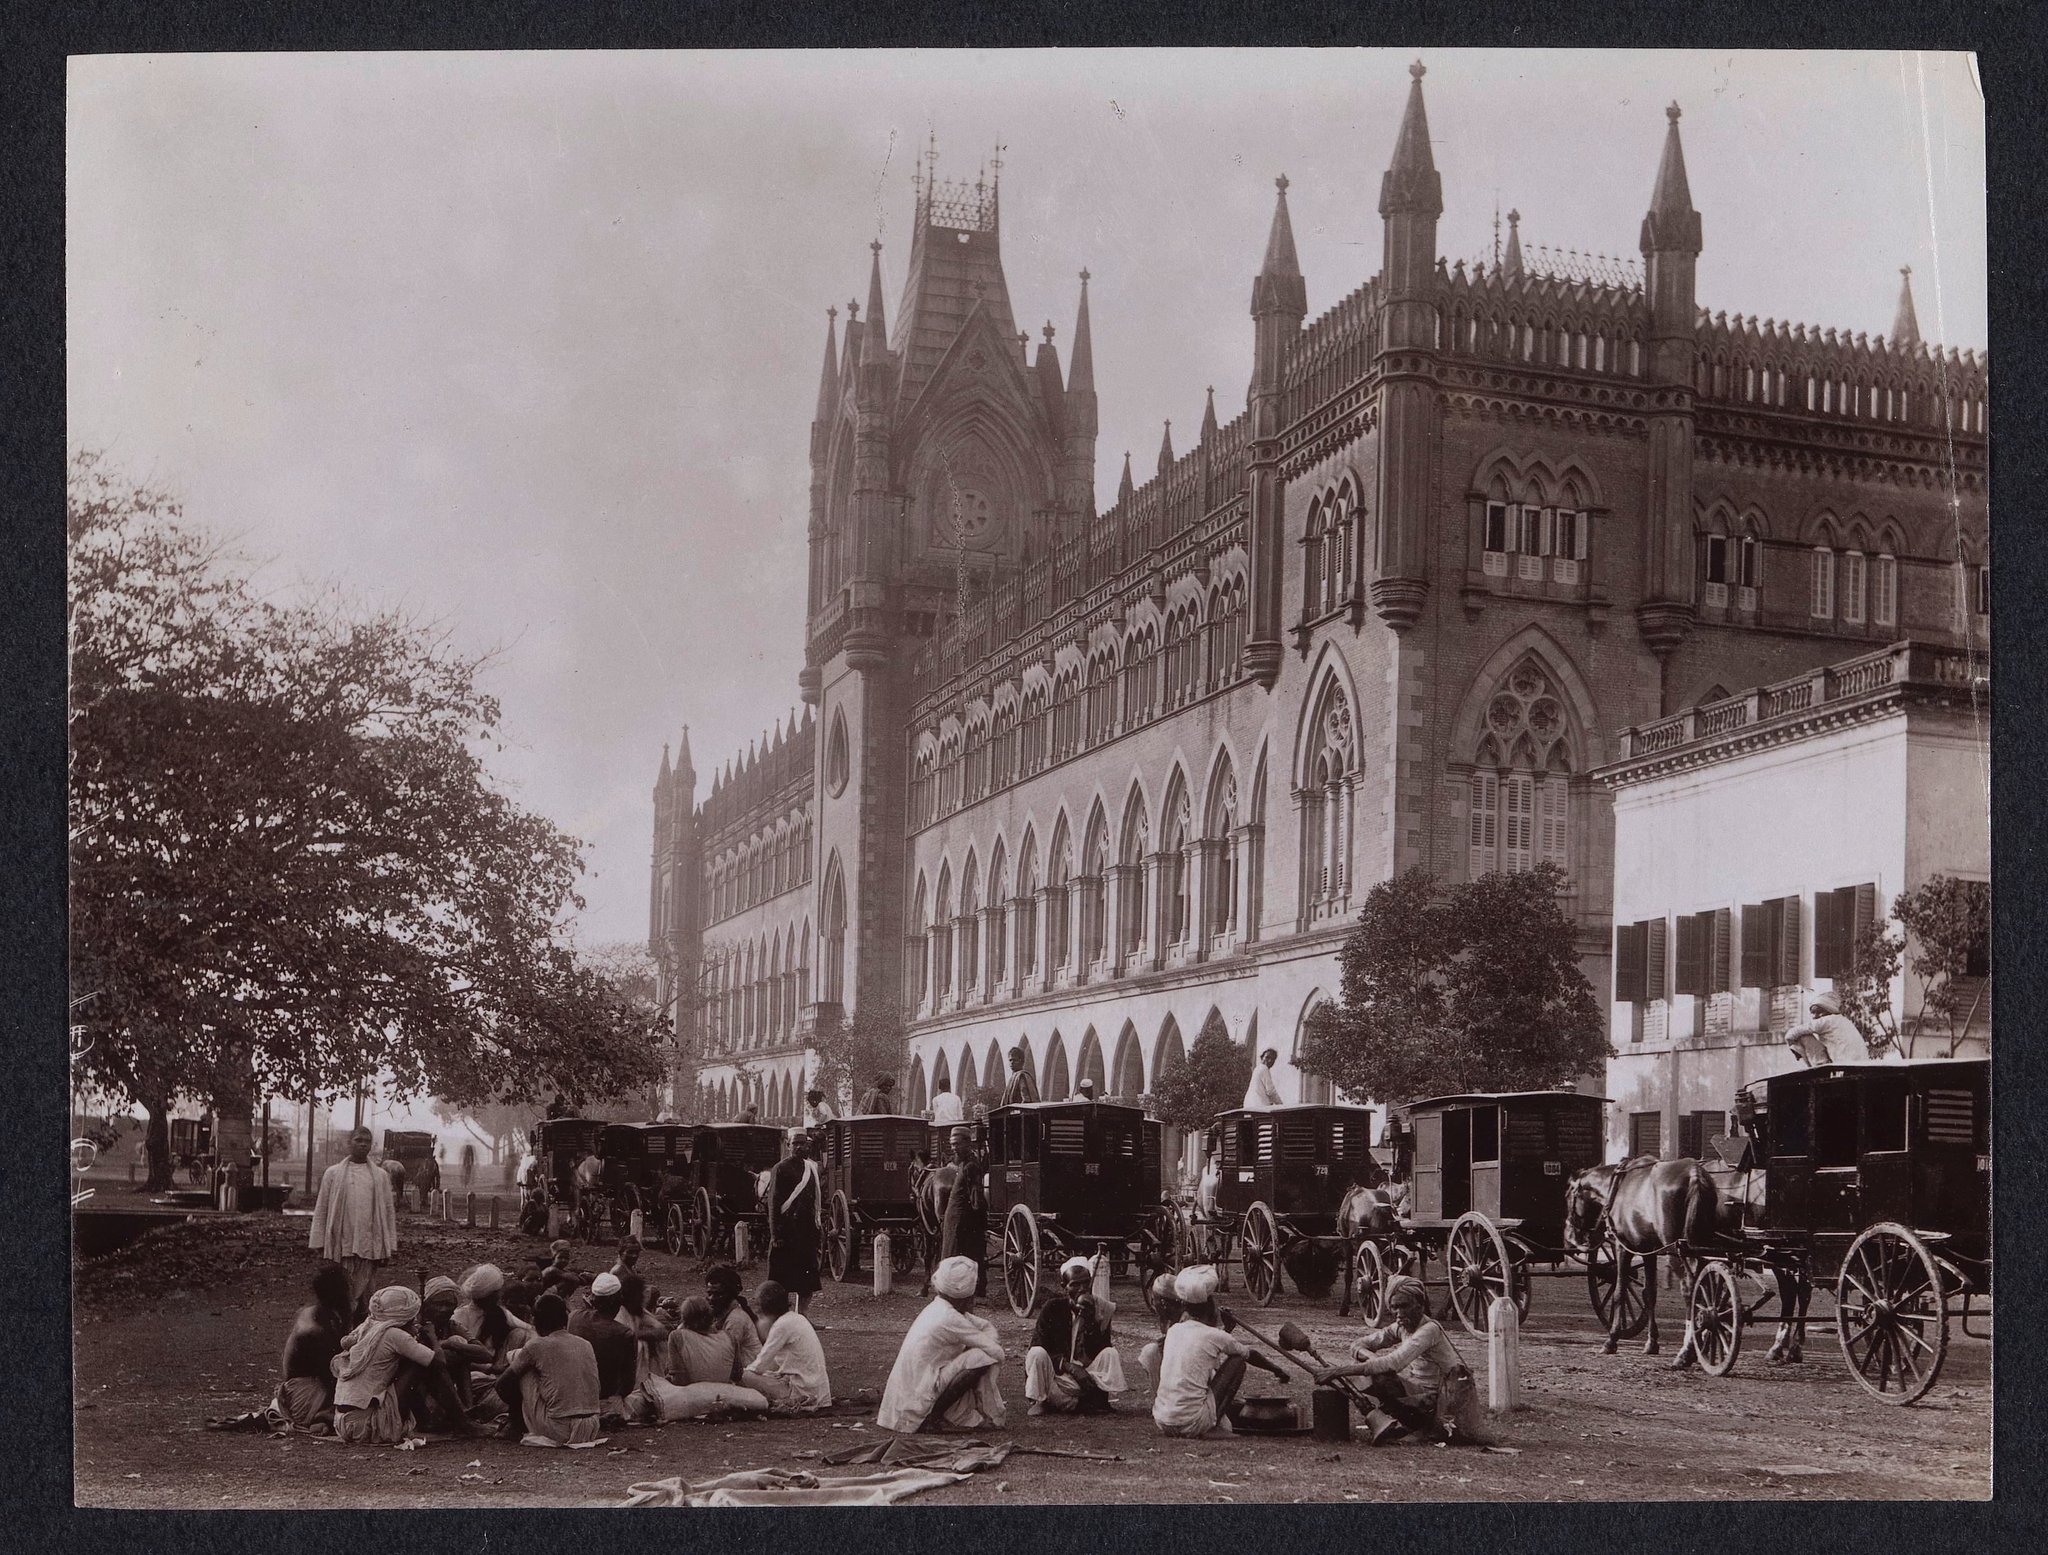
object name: photograph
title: Calcutta High Court, Kolkata, West Bengal, India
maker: Anonymous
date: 1862-1900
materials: paper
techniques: albumen print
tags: court building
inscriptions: number: ‘10559’, inscription: ‘Haalmeijer/ Calcutta’